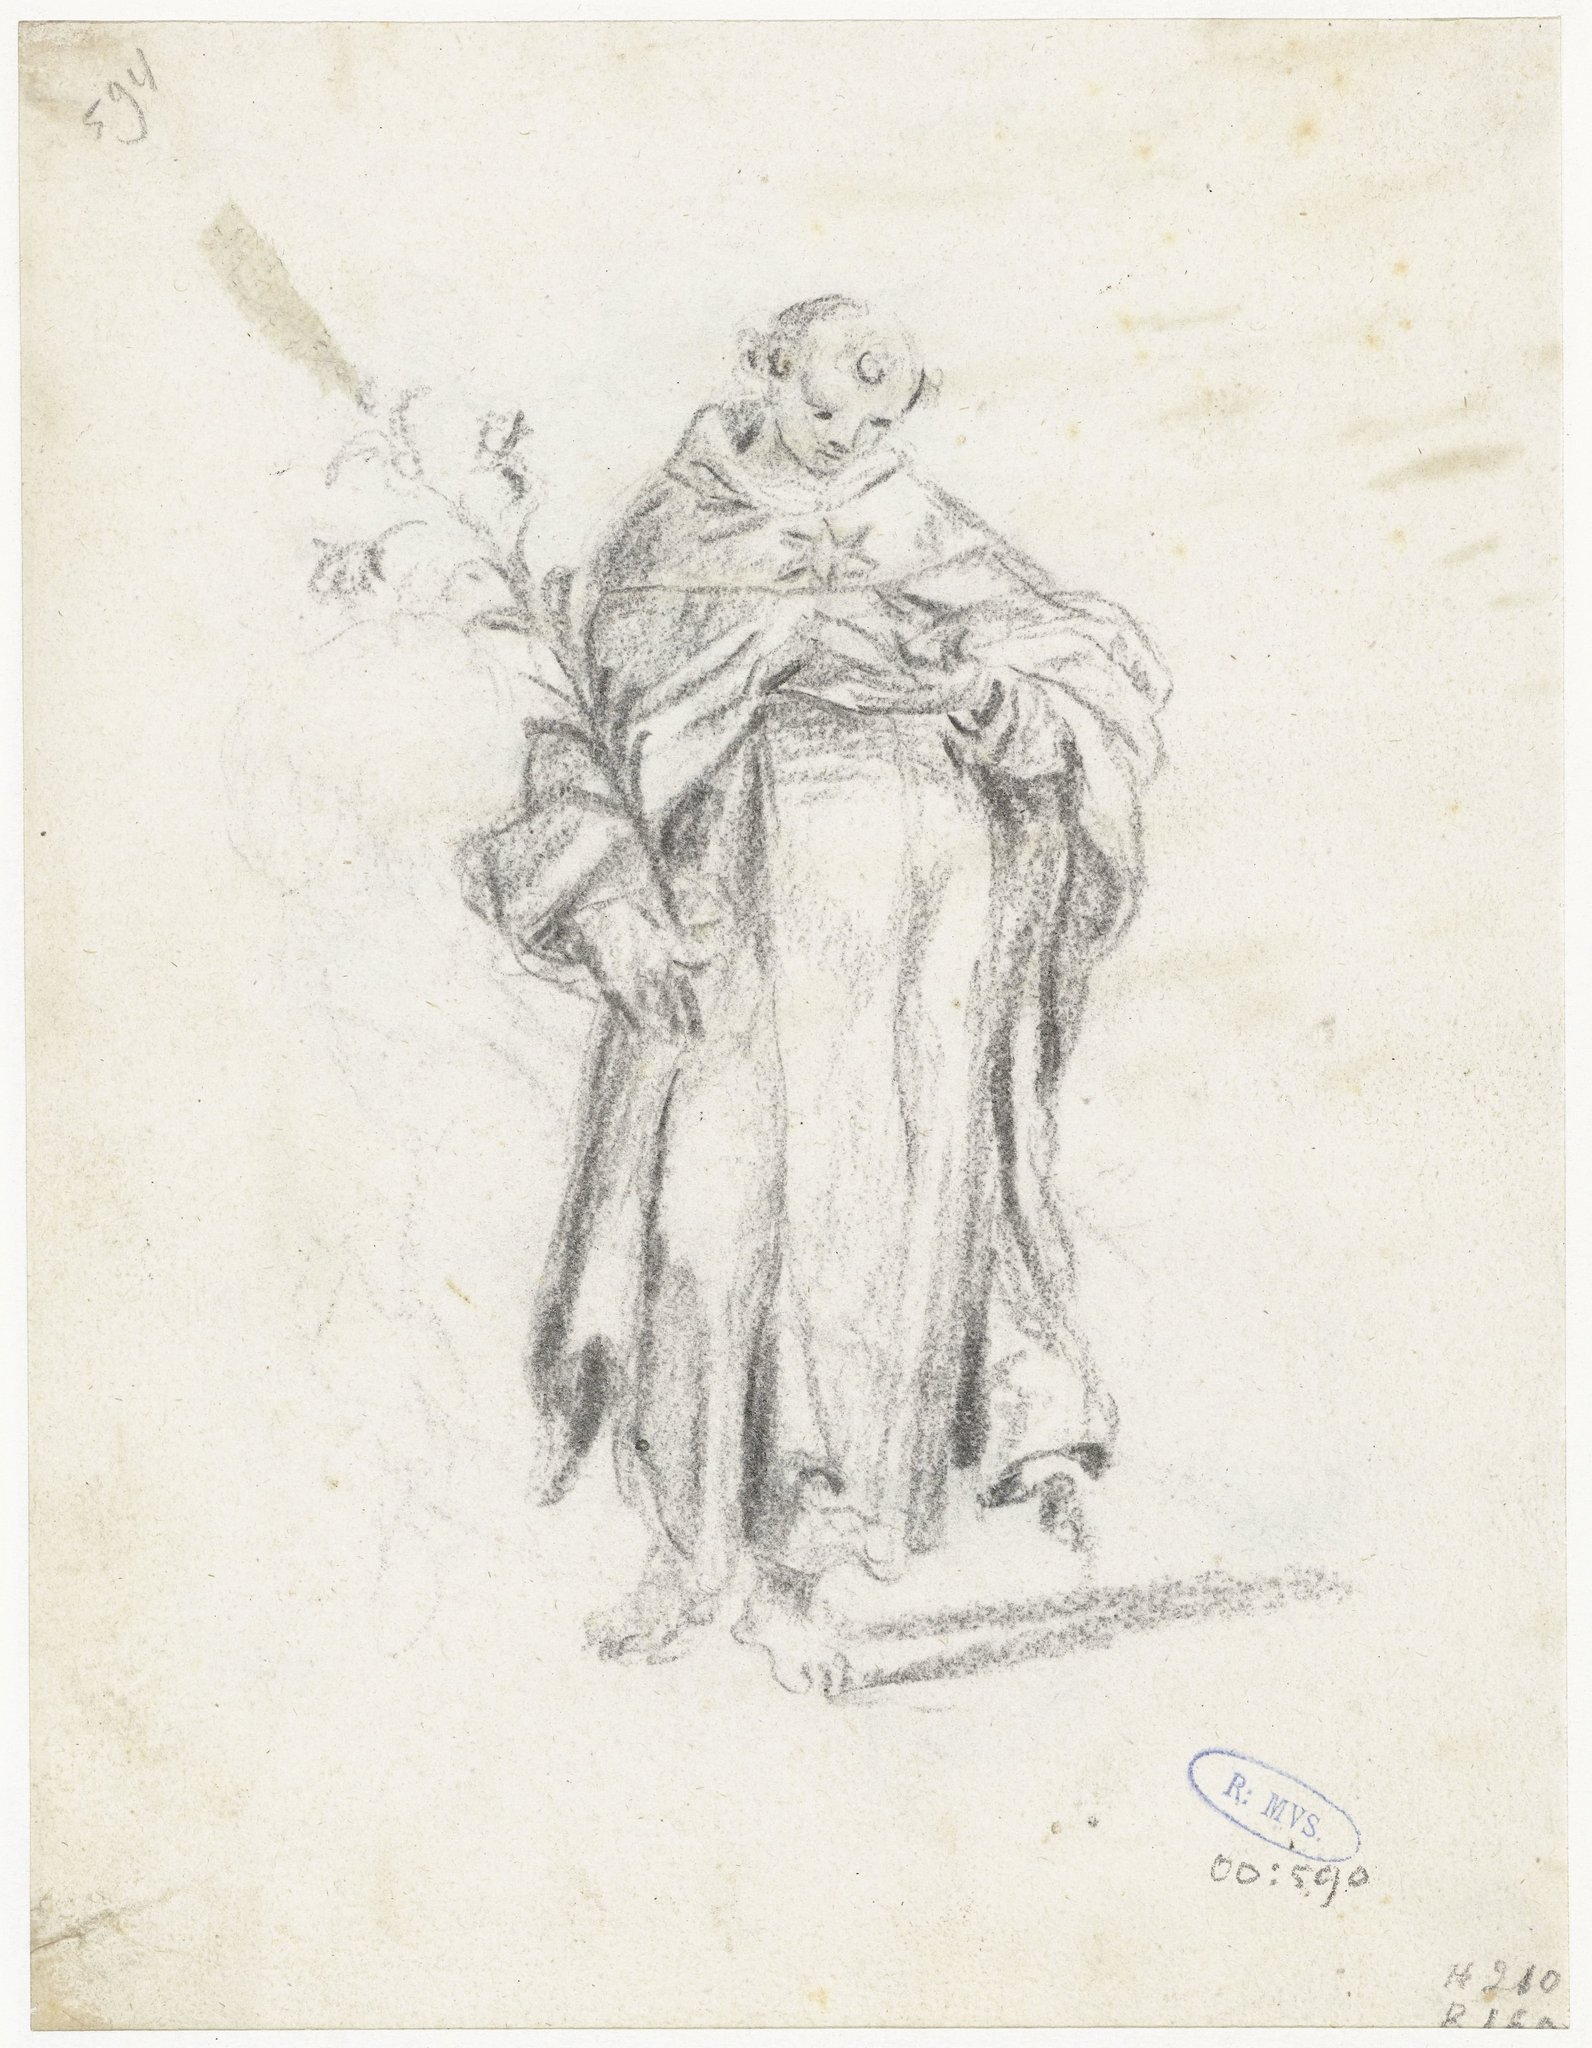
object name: drawing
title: Heilige Dominicus Guzman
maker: moses ter borch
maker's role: draughtsman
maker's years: 1645-1667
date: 1656-1657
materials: chalk, paper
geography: zwolle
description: Kopie naar gravure van A. Wierix naar B. Spranger.